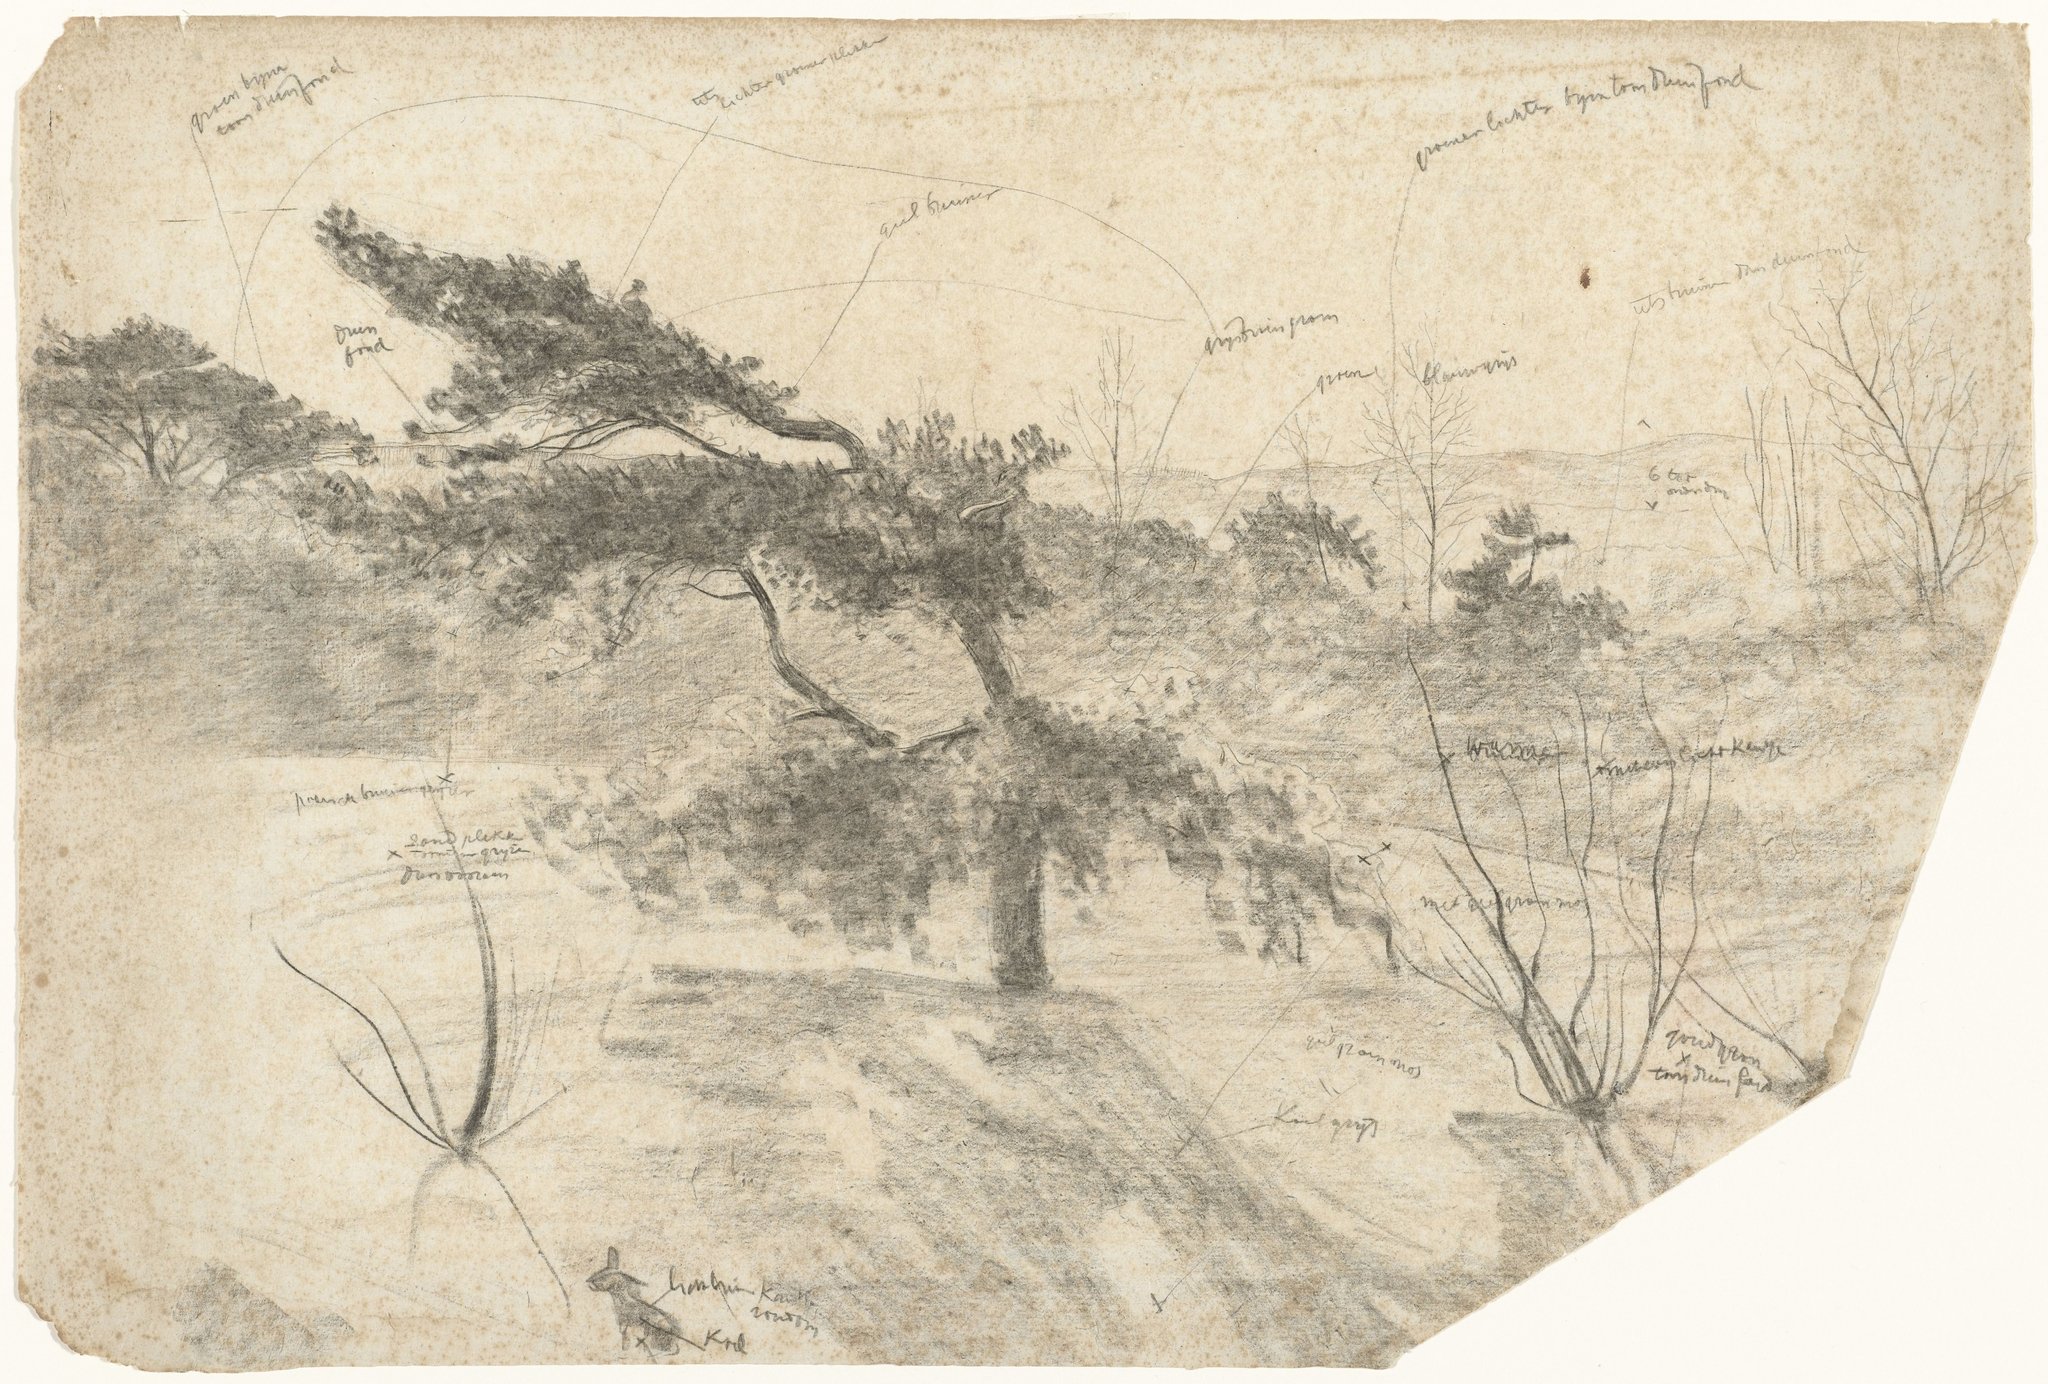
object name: drawing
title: Oude den op open plek, met kleurnotities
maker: gerrit willem dijsselhof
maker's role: designer, draughtsman, print maker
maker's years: 1866-1924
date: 1876-1924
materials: chalk, paper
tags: trees